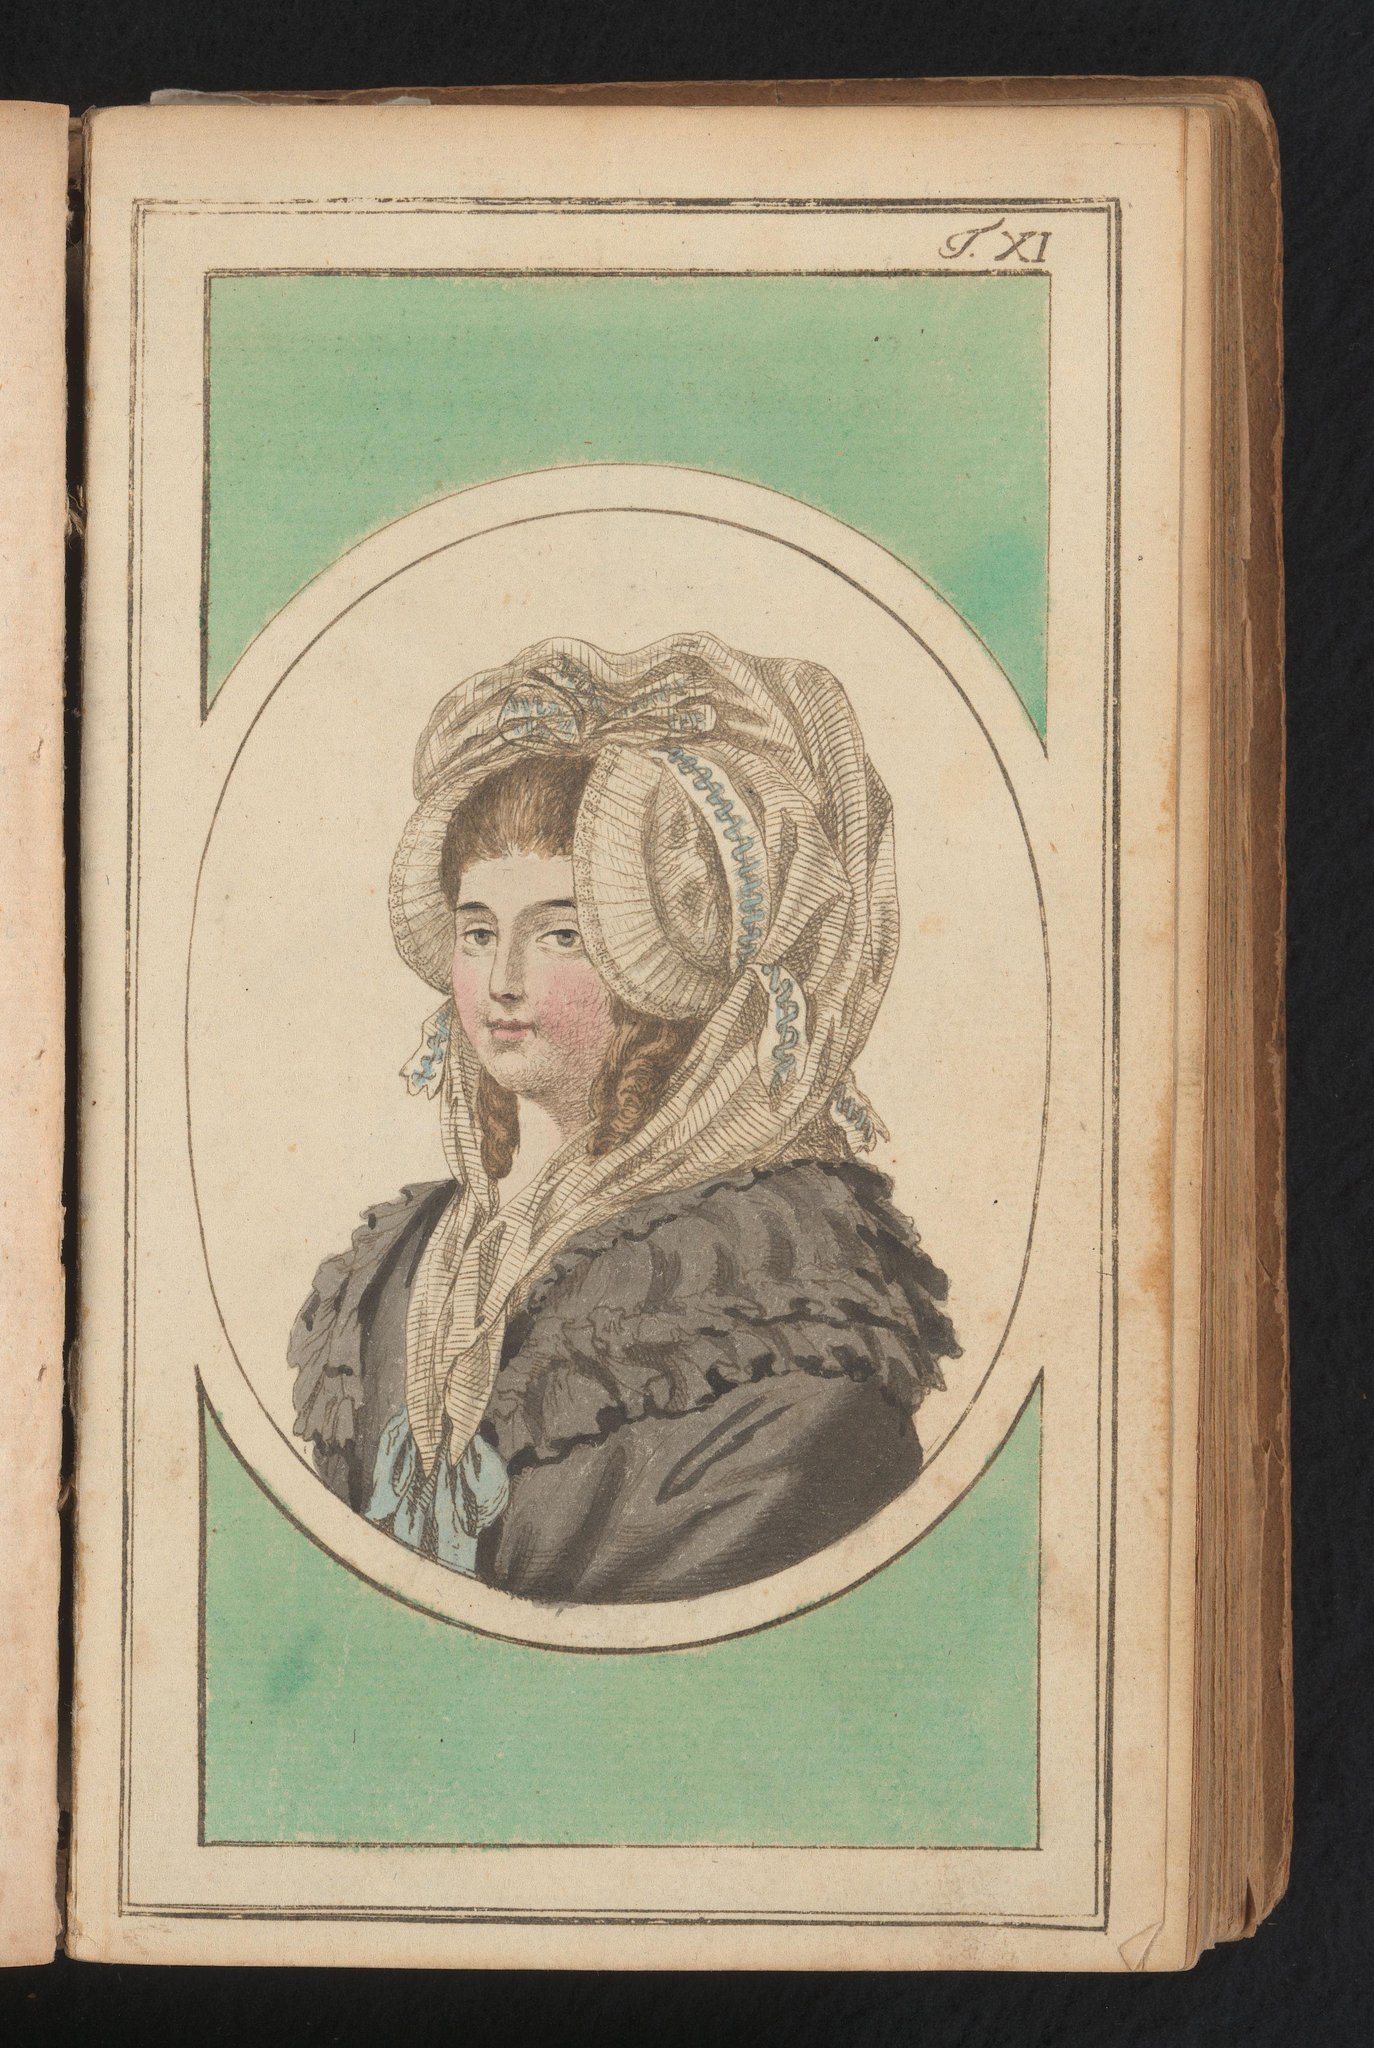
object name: fashion print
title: Journal des Luxus und der Moden 1786, Band I, T. 11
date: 1786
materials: paper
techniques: etching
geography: weimar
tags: head-gear (baigneuse) (+ women's clothes), fashion plates, clothes, costume (+ women's clothes)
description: Vrouwenbuste met kapsel 'à la Conseilere' waarop een grote muts, 'Baigneuse ' genoemd. Prent uit het modetijdschrift Journal des Luxus und der Moden, uitgegeven door Friedrich Justin Bertuch en Georg Melchior Kraus, Weimar, 1786-1826.